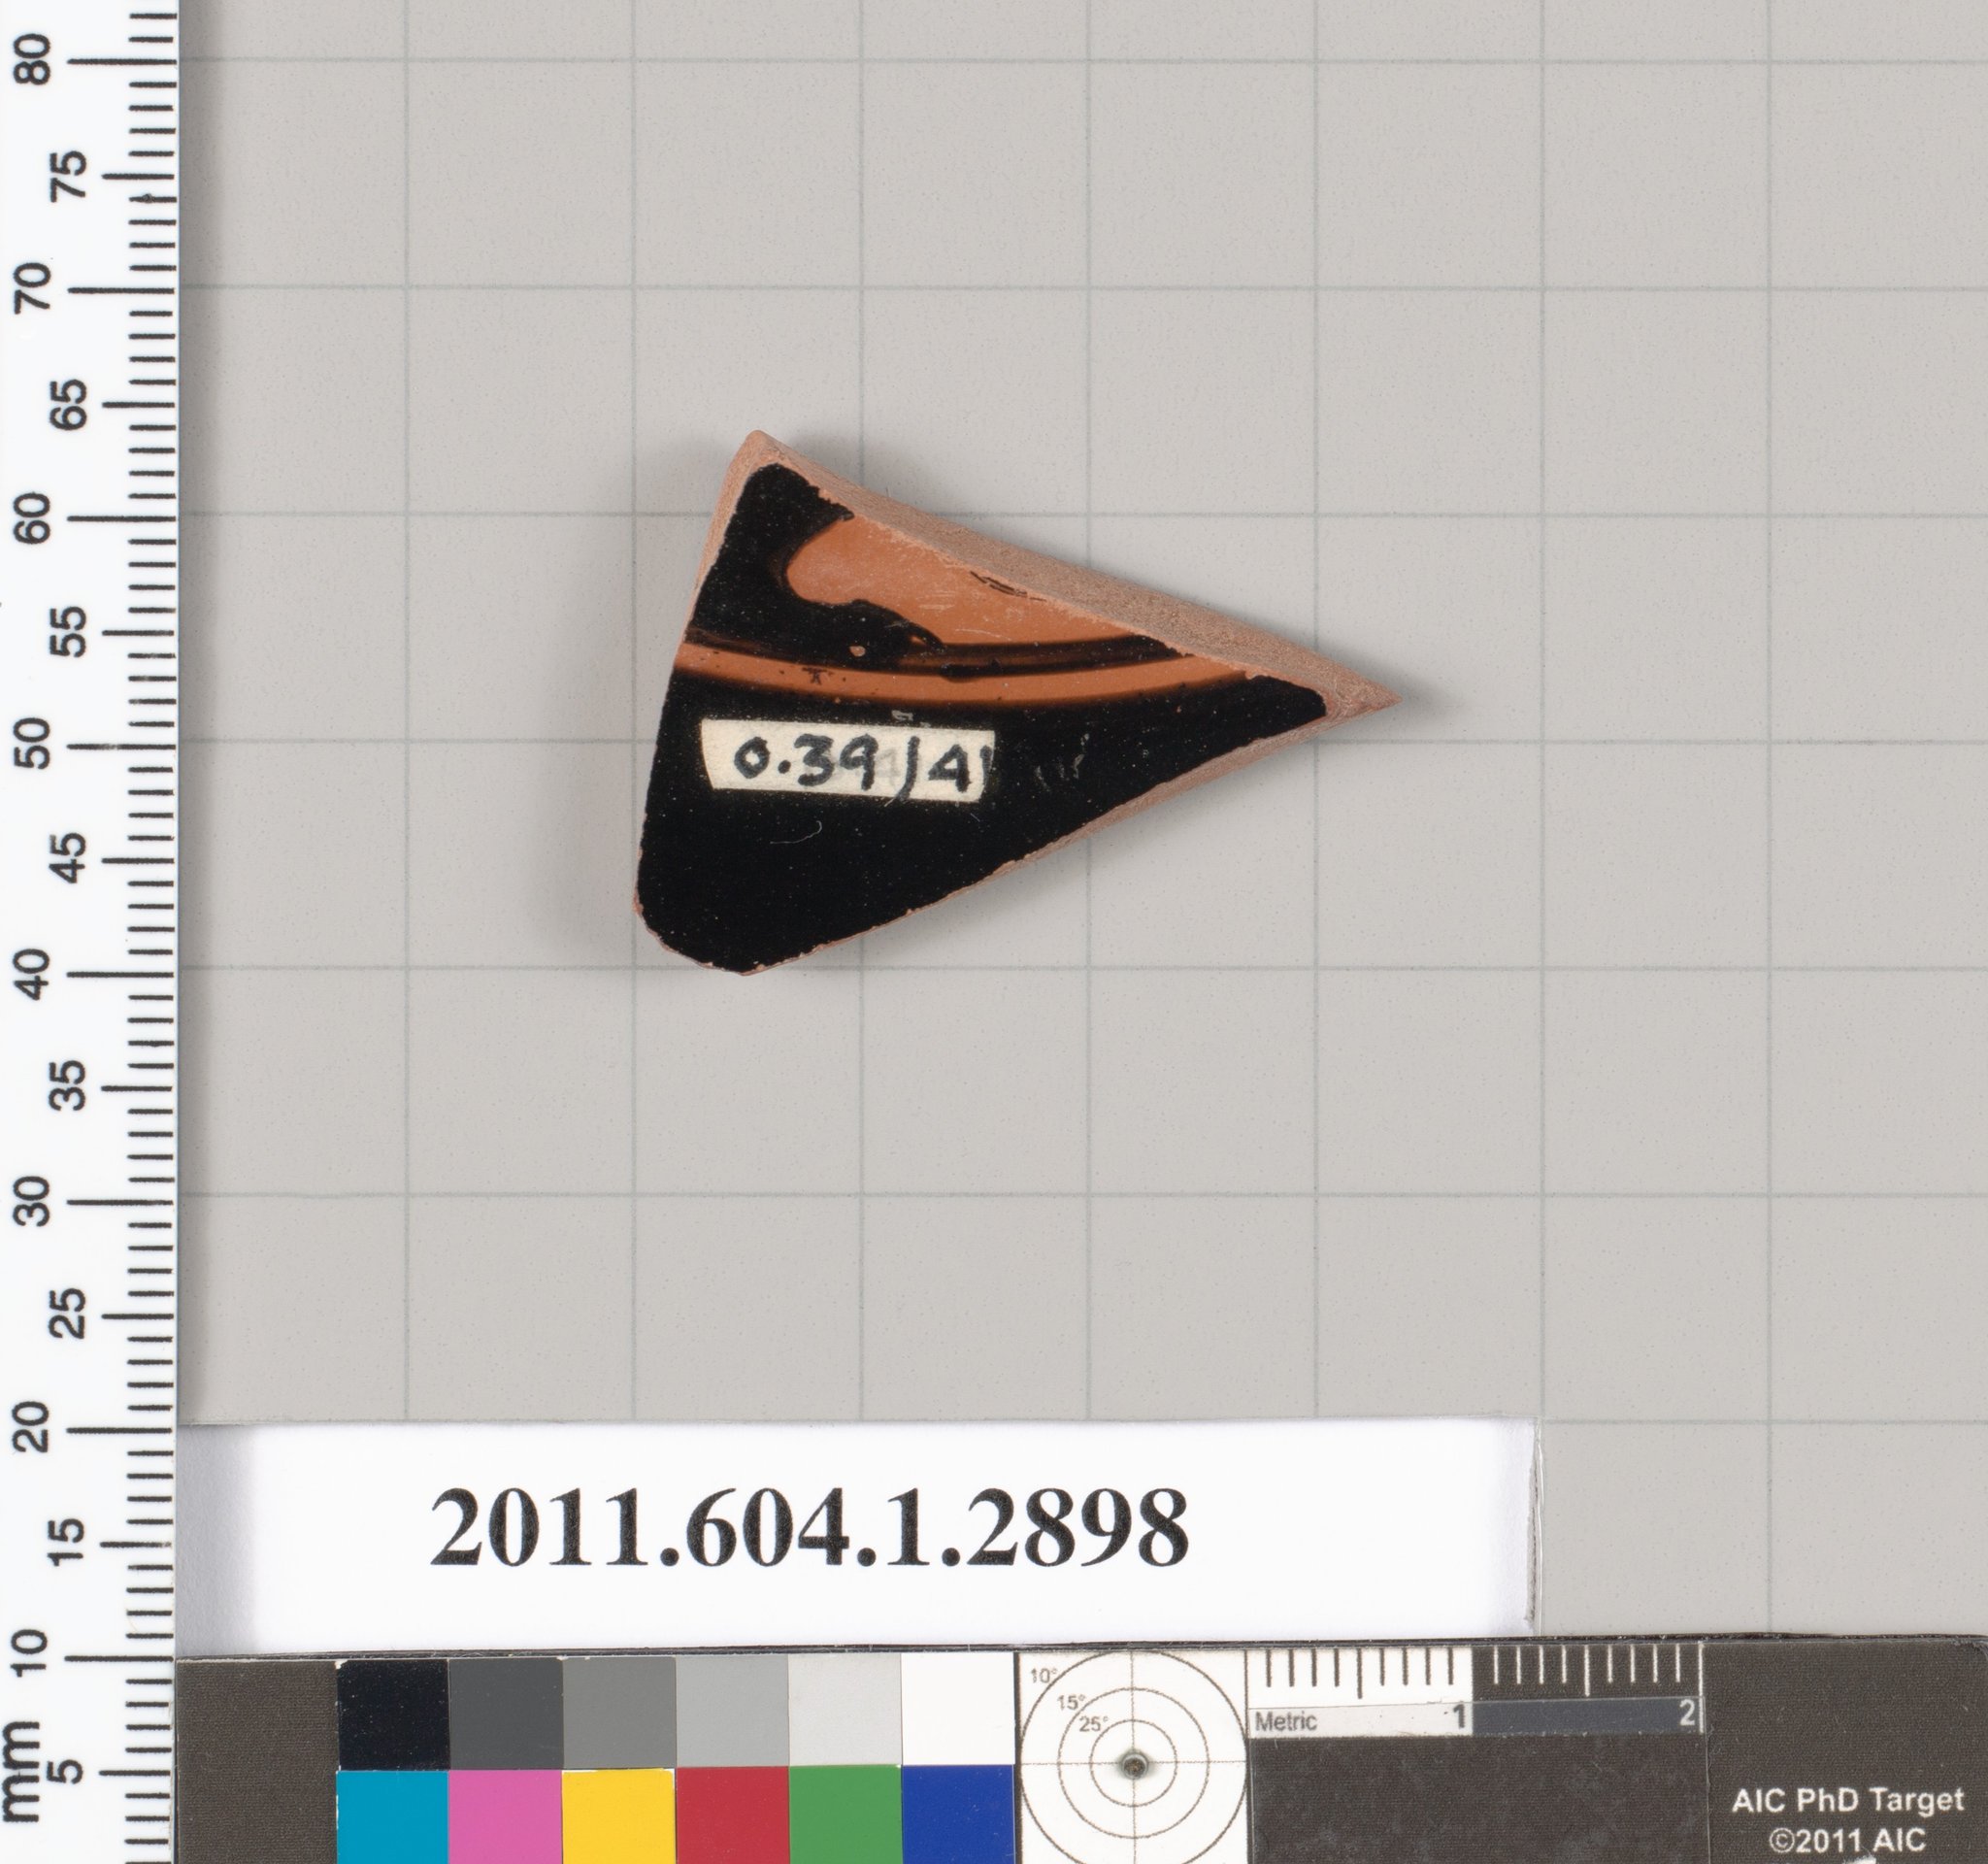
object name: kylix fragment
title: Terracotta fragment of a kylix (drinking cup)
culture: greek, attic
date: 520-500 BCE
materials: terracotta